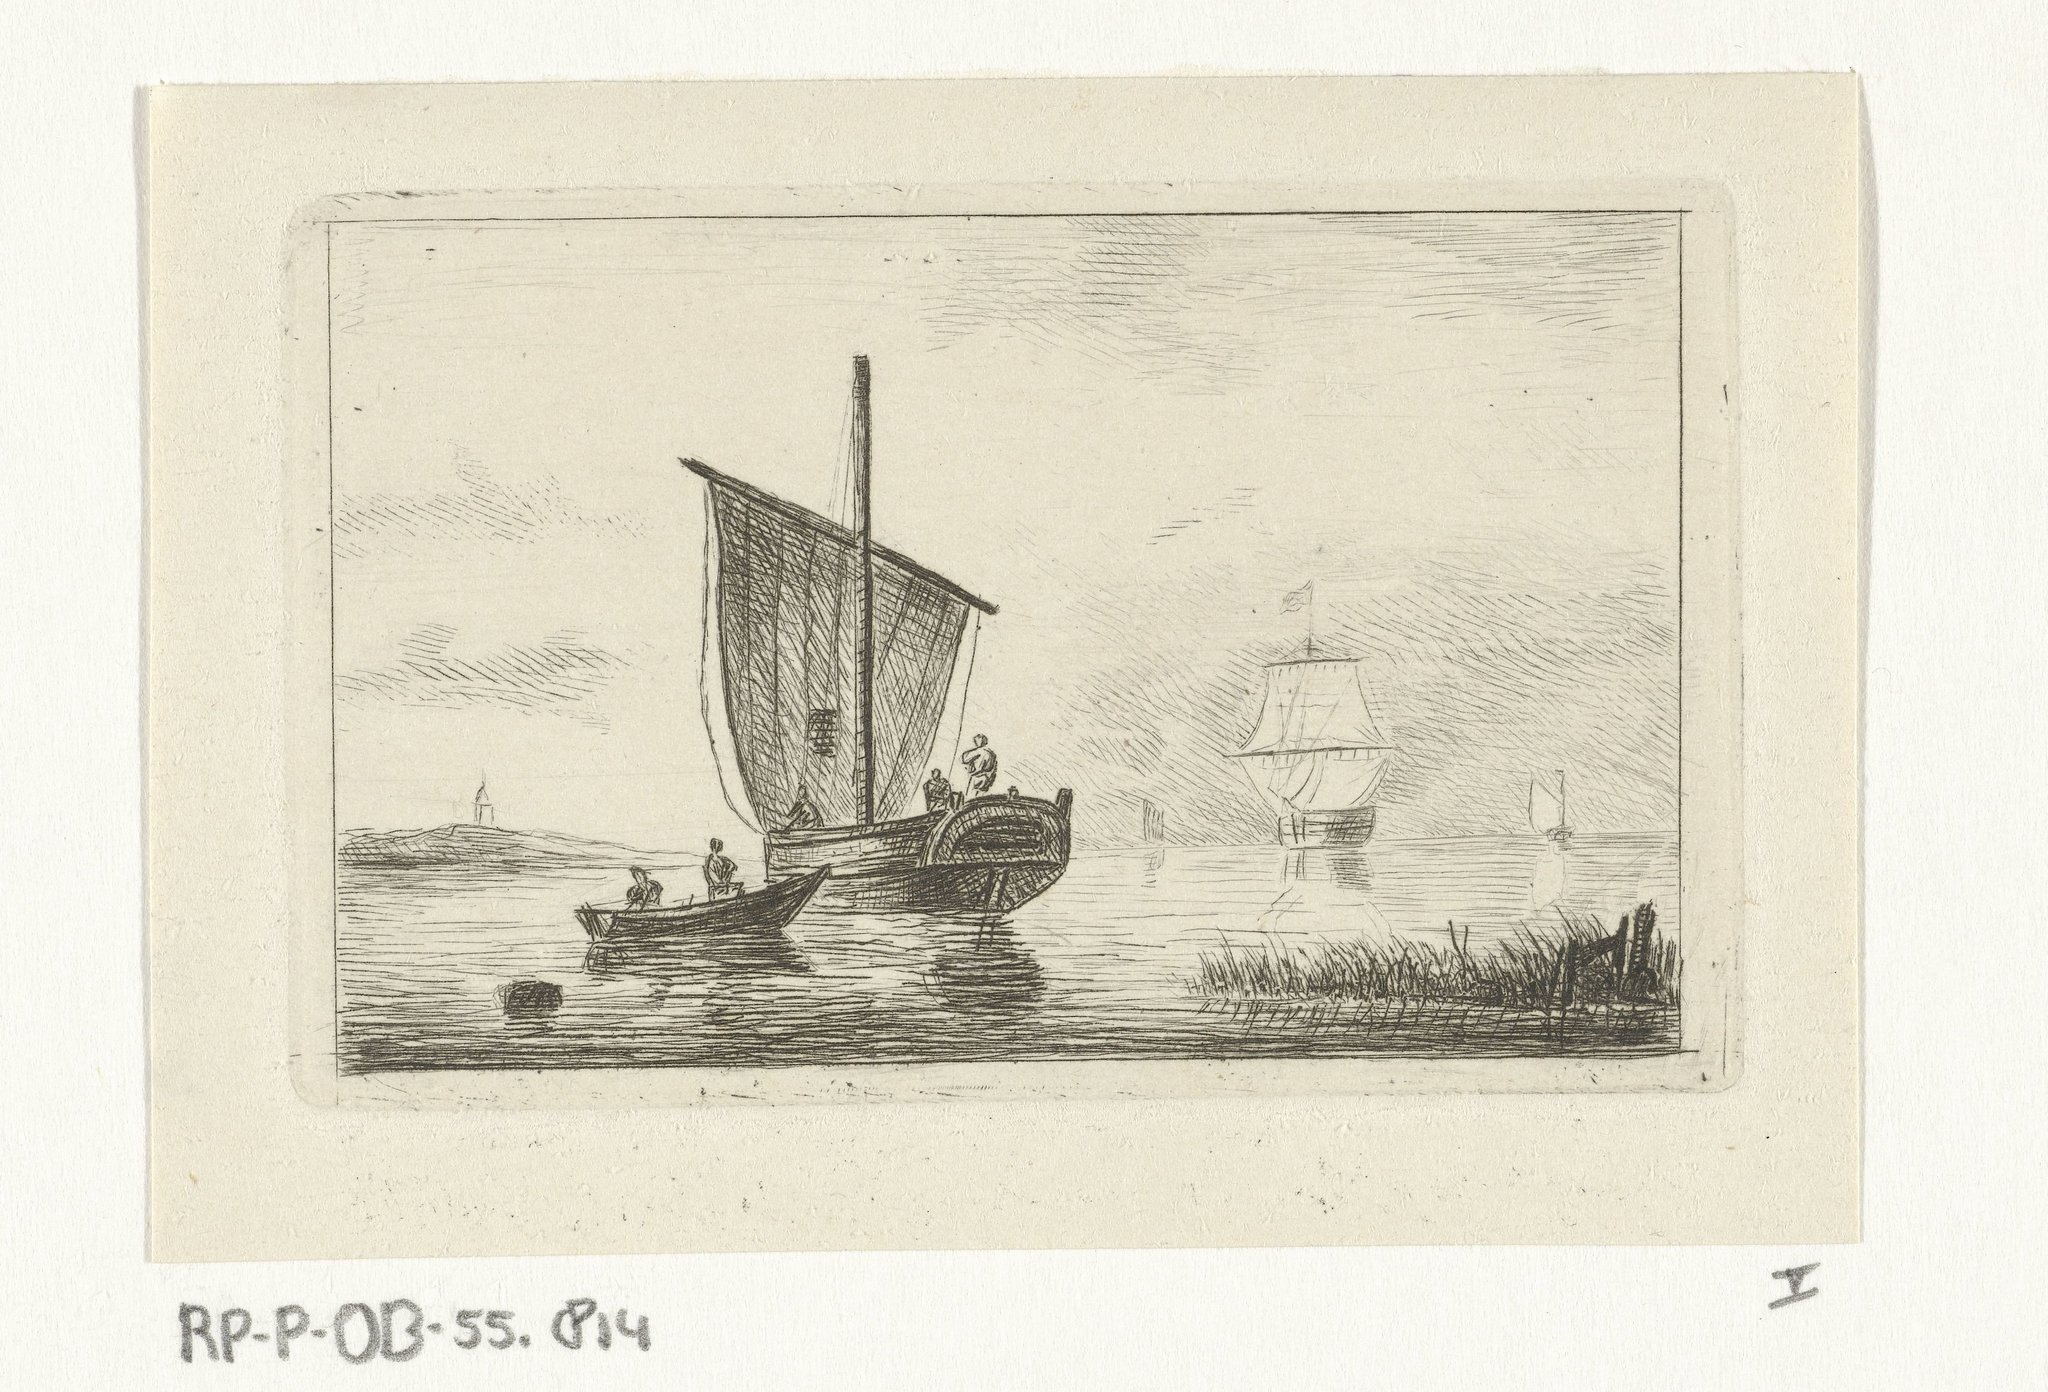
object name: print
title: Riviergezicht met zeilschip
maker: willem gruyter jr.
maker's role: draughtsman, print maker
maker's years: 1817-1880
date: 1832-1880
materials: paper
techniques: etching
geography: amsterdam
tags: rowing-boat, canoe, etc., sailing-ship, sailing-boat (+ view ~ vehicle, ship, etc.)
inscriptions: collector's mark: Lugt 2165, collector's mark: Lugt 2228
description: Riviergezicht met zeilschip, van achteren gezien, en een roeiboot.